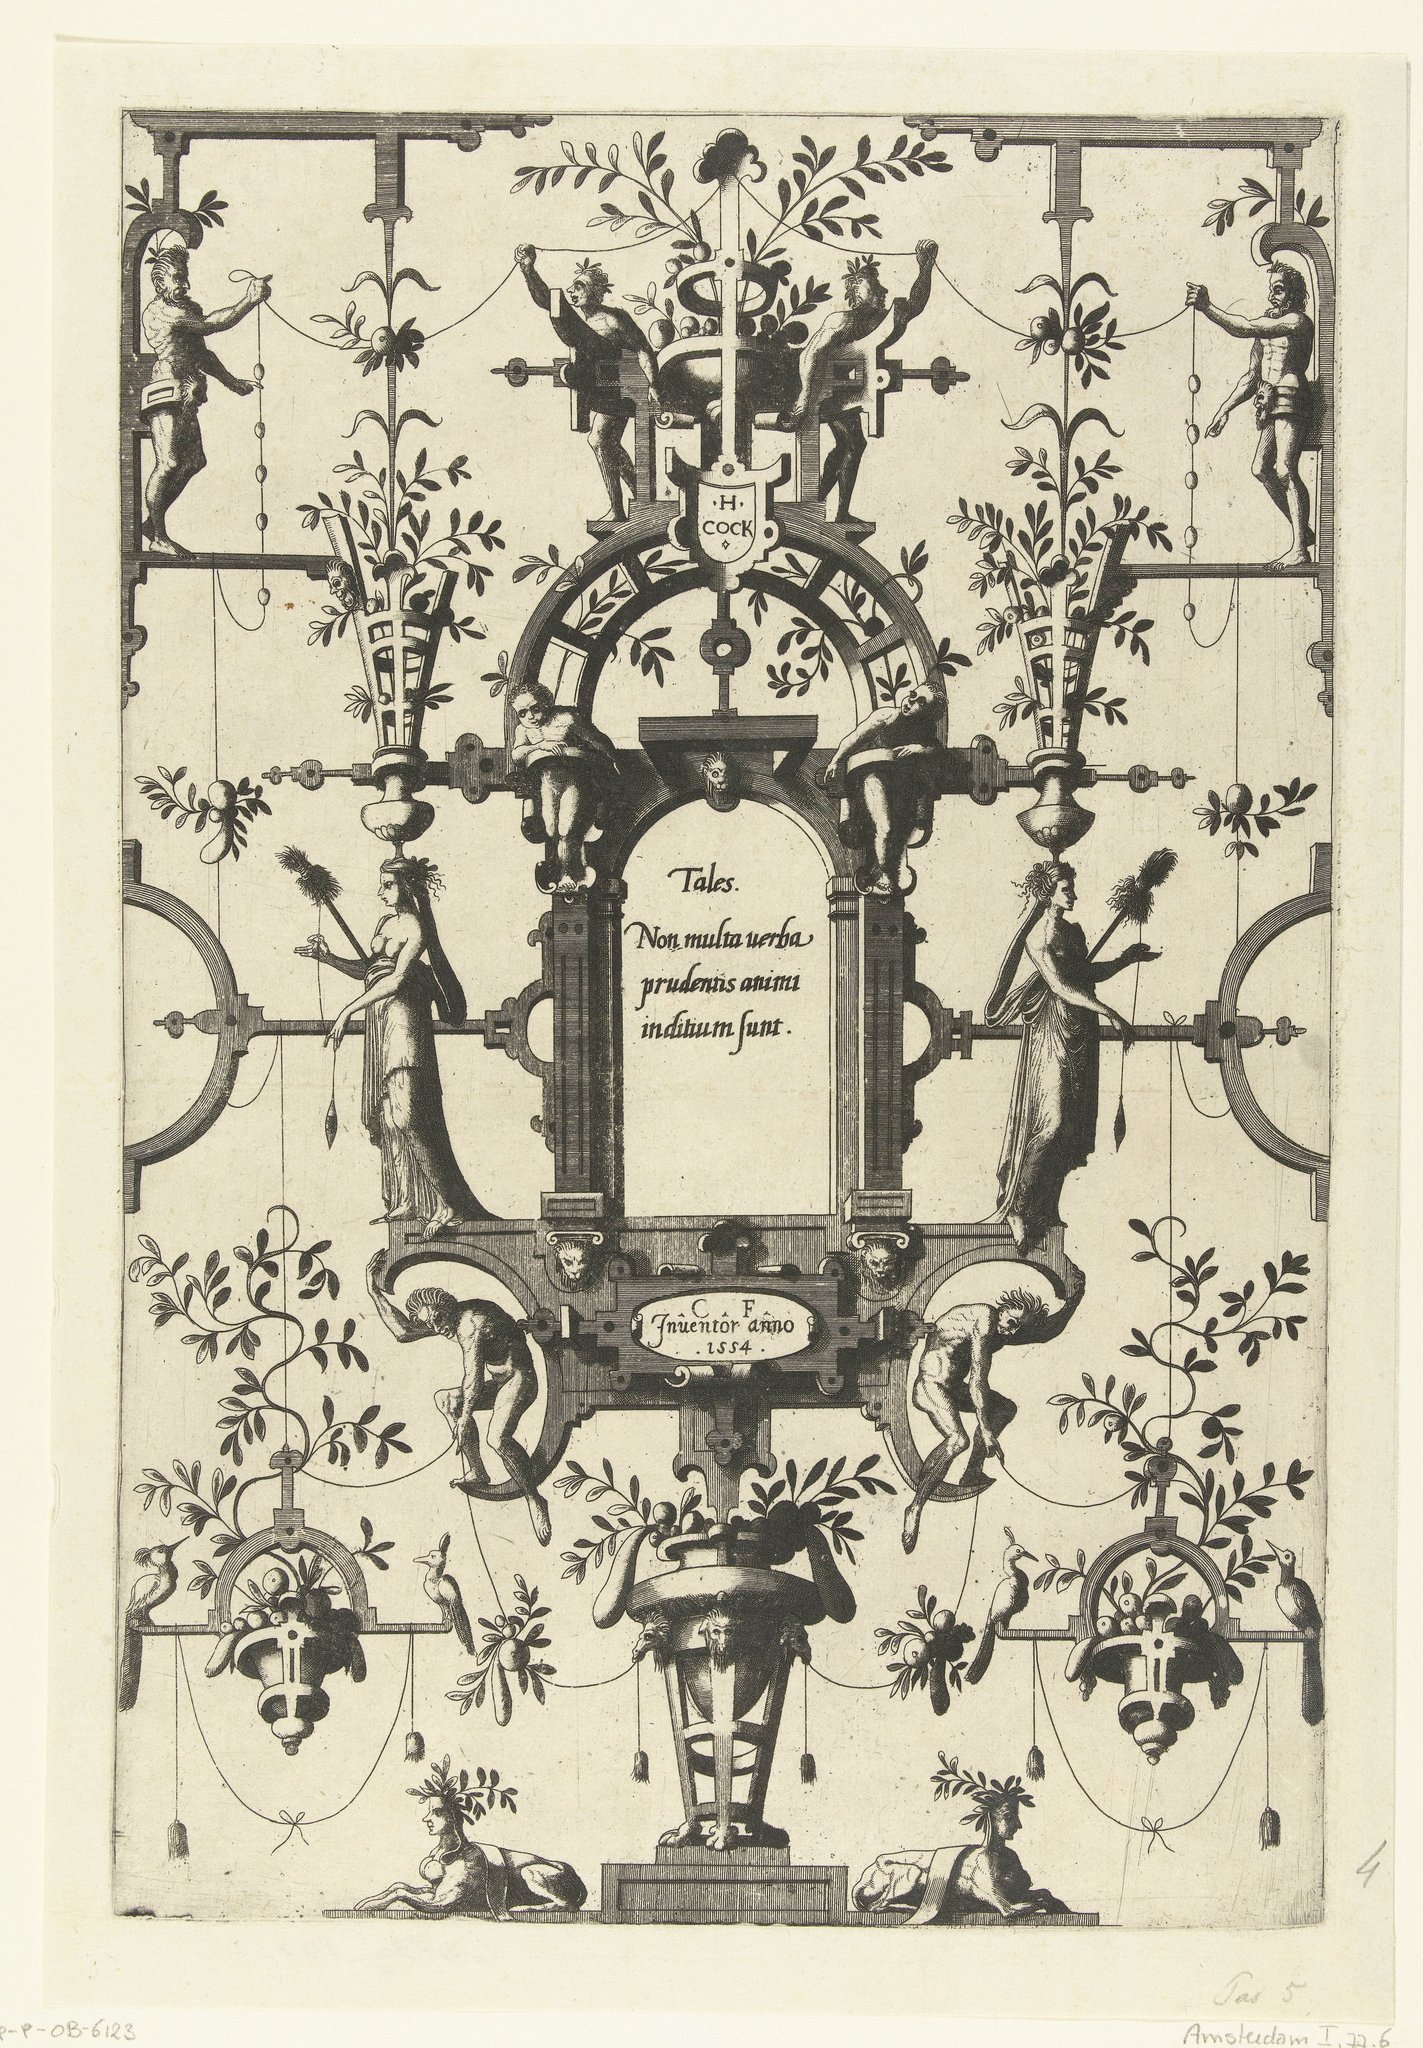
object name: ornament print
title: Tales./ Non multa verba/ prudentis animi/ iuditium sunt.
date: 1554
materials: paper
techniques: etching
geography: netherlands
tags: spindle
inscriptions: signature and date: ‘C.F. Inventor anno 1554’, address: ‘H. Cock’, title: ‘Tales: non multa verba prudentis animi inditium sunt’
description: Cartouche met tekst, geflankeerd door twee vrouwen met spinrokken. Onderaan liggen twee sfinxen. Hoort bij serie van 6 bladen.